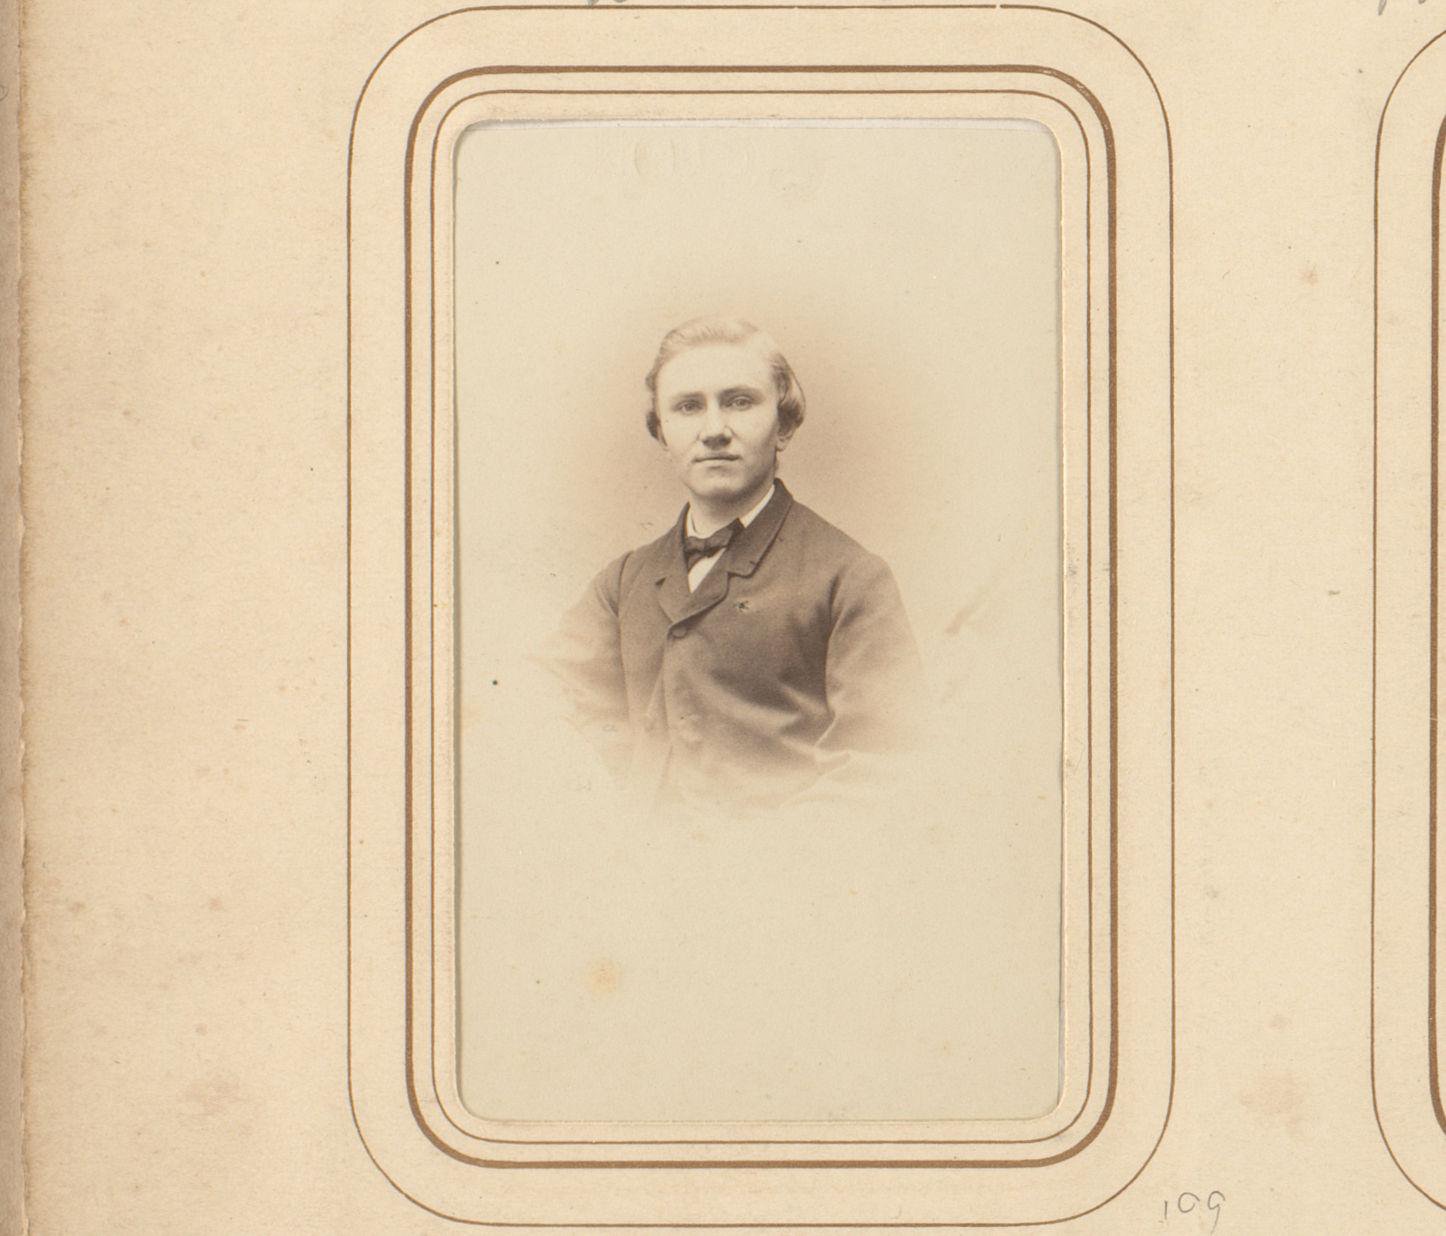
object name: album leaf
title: Portret van een man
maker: albert greiner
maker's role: fotograaf, fotostudio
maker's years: 1833-1890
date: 1865-1890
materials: cardboard, photographic support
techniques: albumen print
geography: amsterdam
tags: adult man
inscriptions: inscription: ‘A. Greiner, Phot.’, inscription: ‘A. Greiner/ Photograf/ Nieuwendijk L. 87/ Amsterdam.’